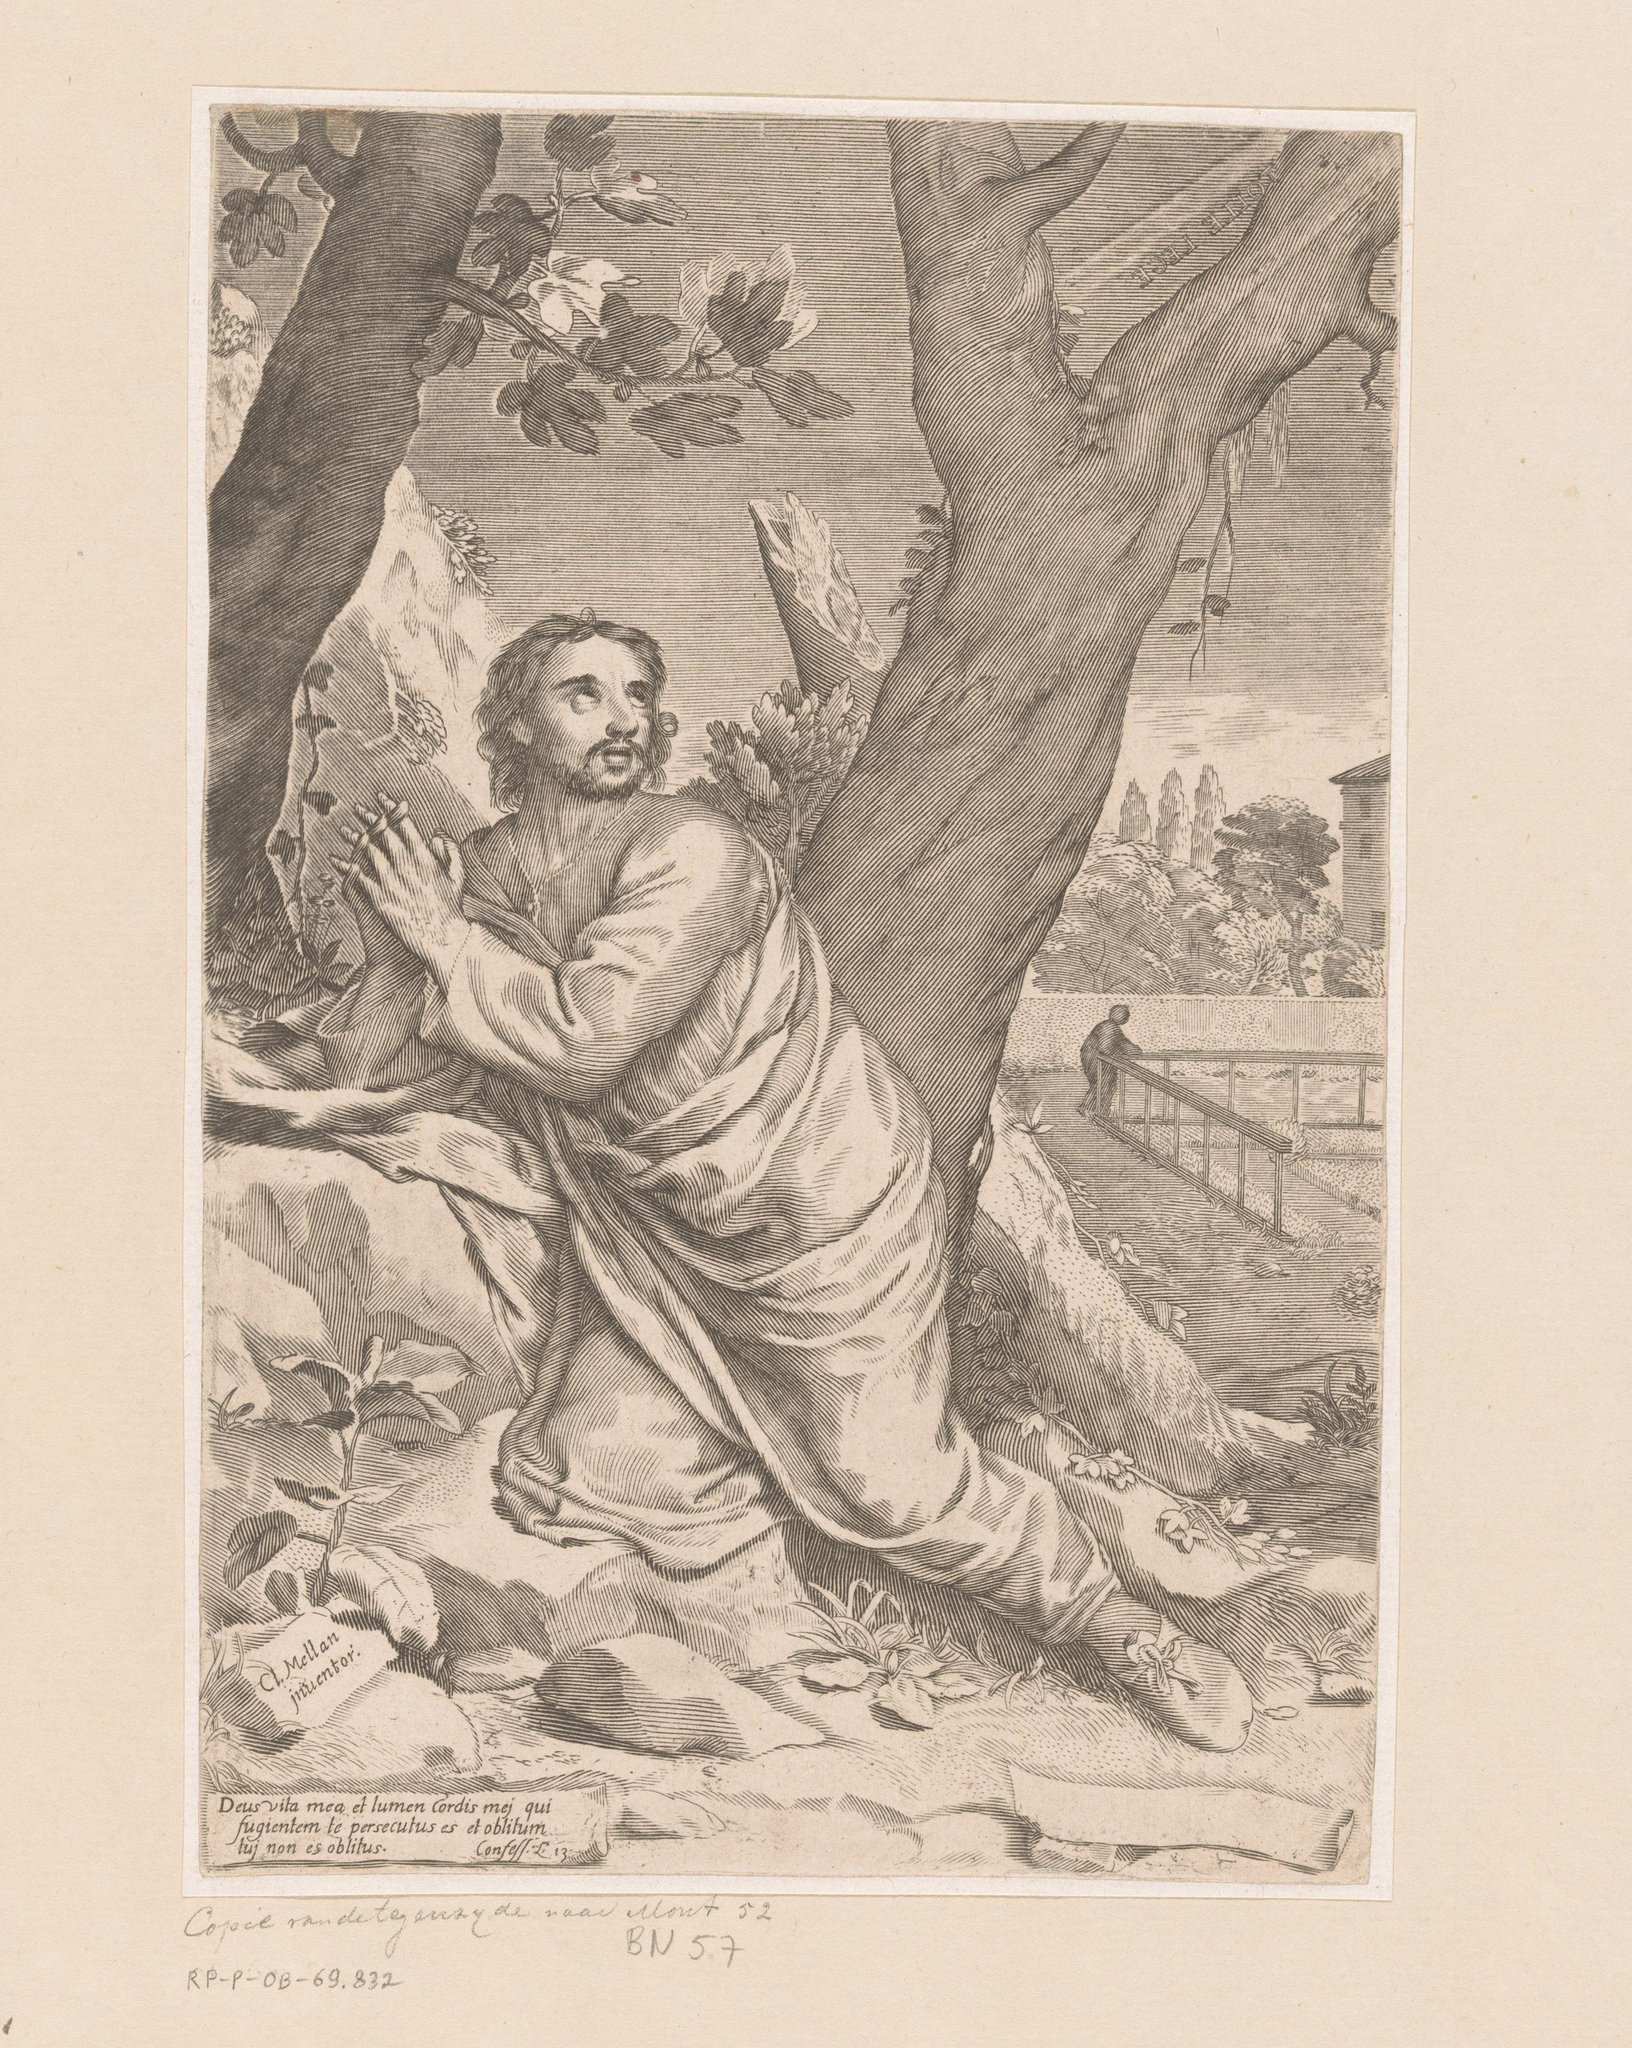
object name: print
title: Biddende H. Augustinus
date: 1608-1688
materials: paper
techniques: engraving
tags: augustine, bishop of hippo; possible attributes: arrows piercing his breast, book, child with spoon, flaming heart, heart (pierced with arrows), pen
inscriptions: collector's mark: Lugt 240